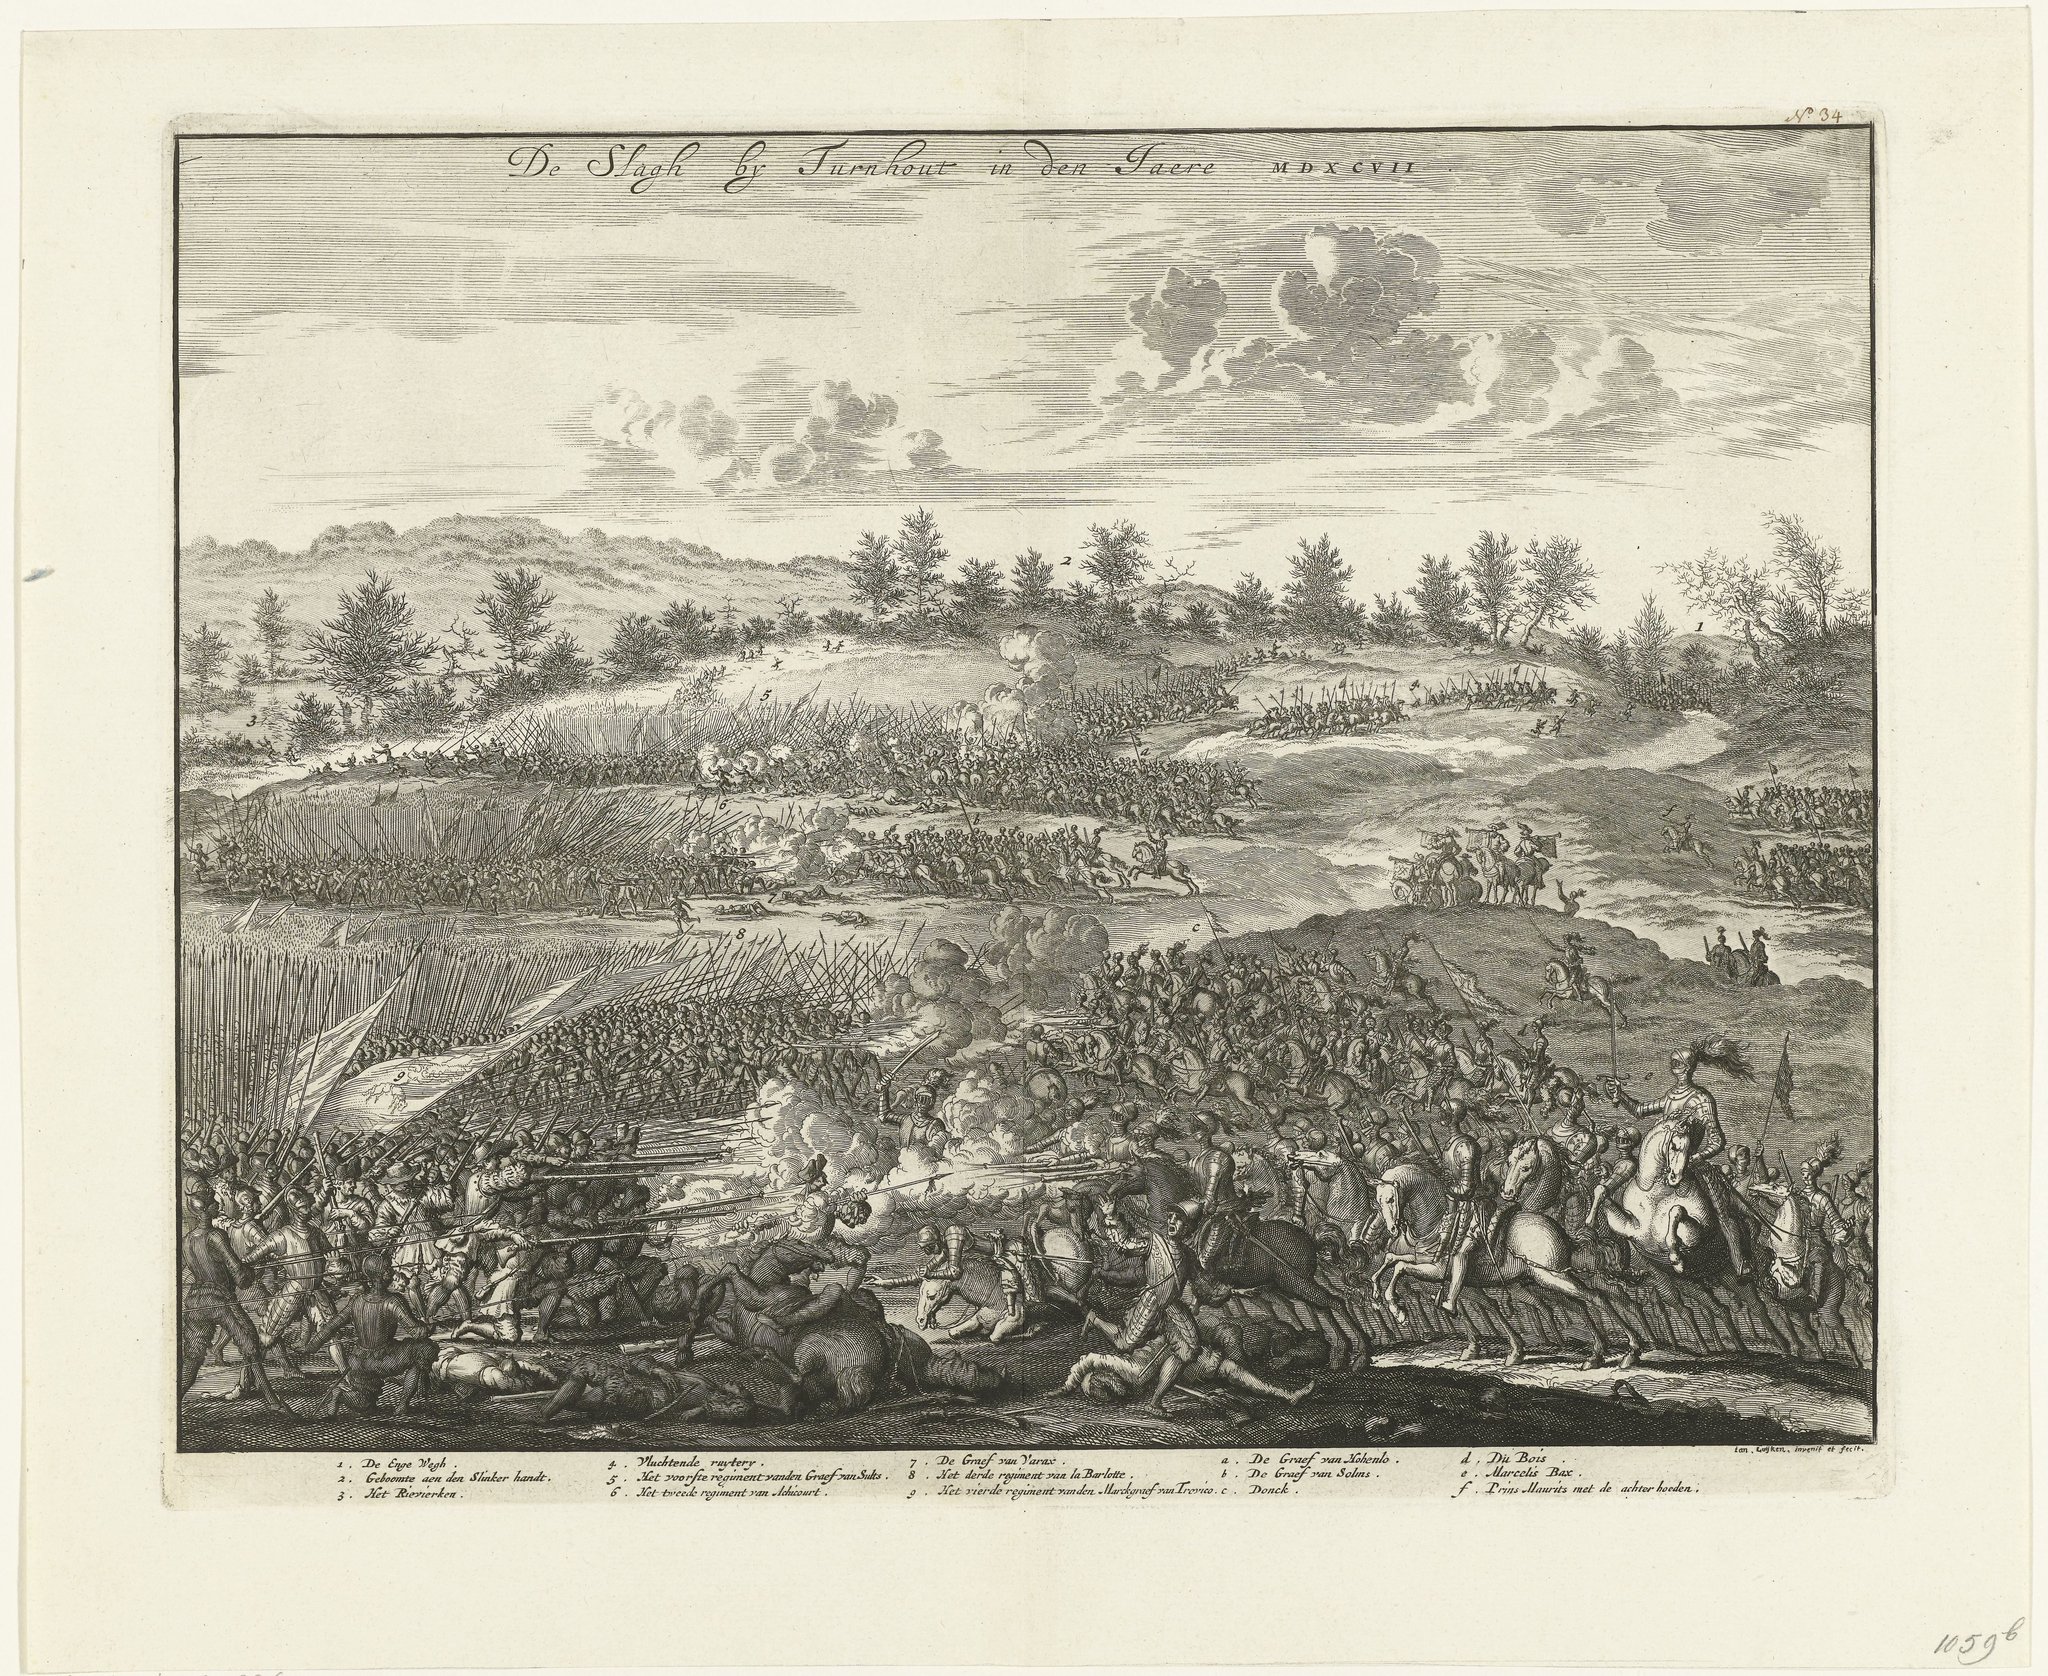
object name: history print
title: De Slagh by Turnhout in den Jaere MDXCVII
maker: jan luyken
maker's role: draughtsman, print maker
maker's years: 1649-1712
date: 1679-1681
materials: paper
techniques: engraving, etching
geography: northern netherlands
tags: the hague, maurice (prince of orange), battle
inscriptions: inscription: ‘No. 34’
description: Deze staat ter voorbereiding voor gebruik als illustratie in: J. le Clerc, Geschiedenissen der Vereenigde Nederlanden, sedert den aanvang van die Republyk tot op den Vrede van Utrecht in 't jaar 1713 en het Tractaat van Barriere in 't jaar 1715 gesloten, Z. Chatelain, Amsterdam 1730, 3 delen.